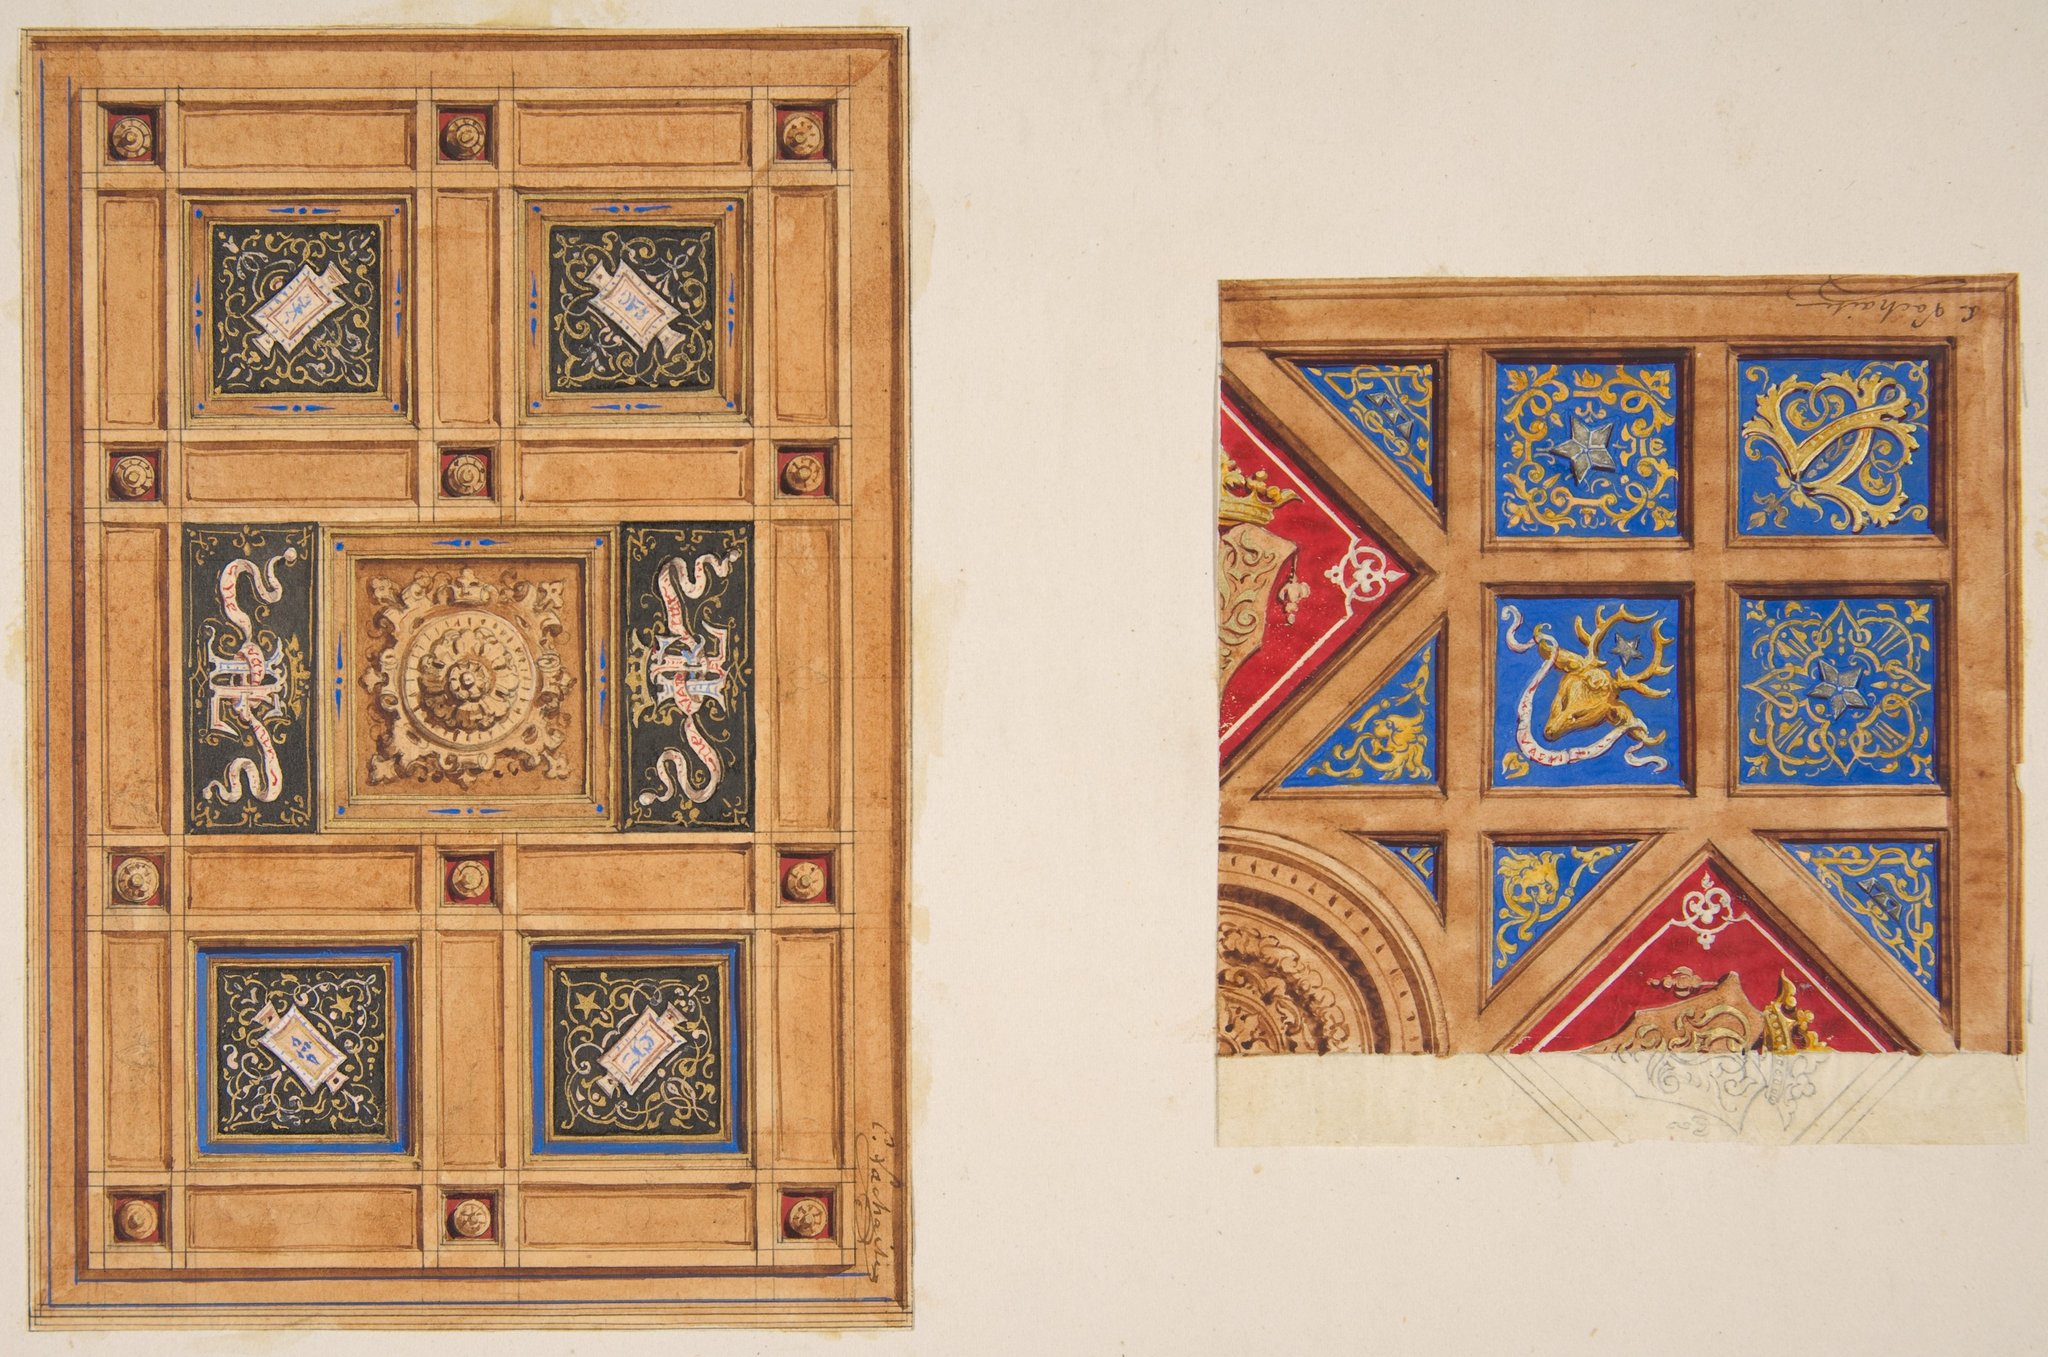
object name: drawing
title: Two designs for paneled ceiling with painted decoration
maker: jules-edmond-charles lachaise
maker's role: artist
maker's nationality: french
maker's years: 1897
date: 1801-1900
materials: gold paint, ink, paper, watercolor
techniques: pen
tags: ceilings